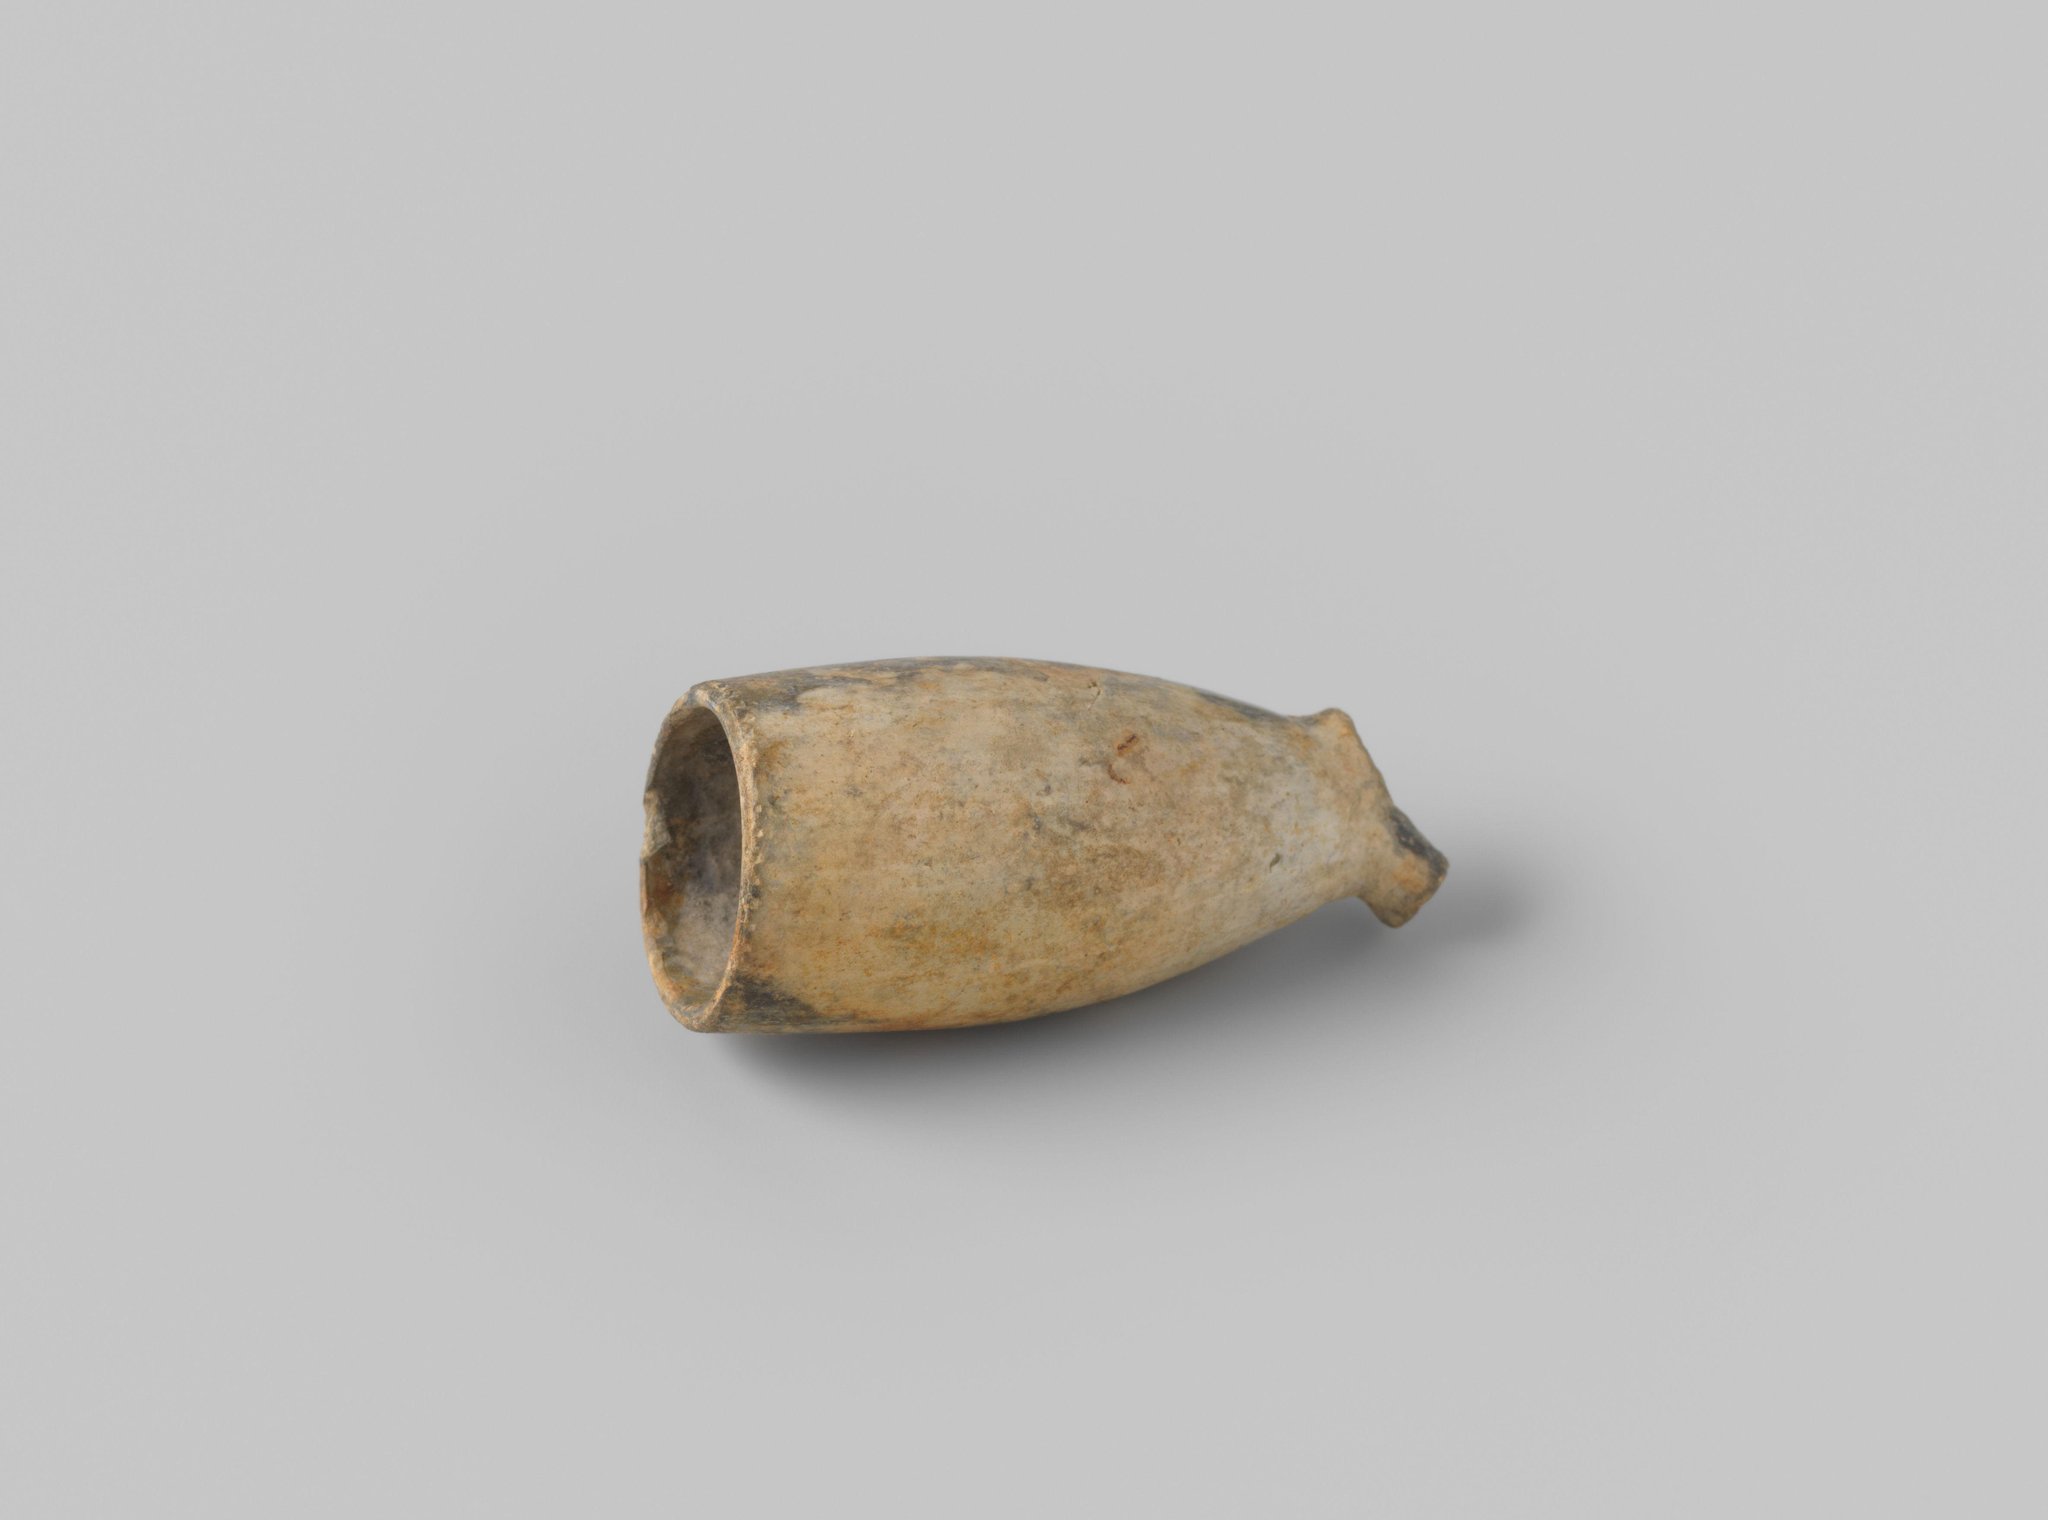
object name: pipe bowl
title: Pijpenkop uit het wrak van de Oost-Indiëvaarder Hollandia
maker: Anonymous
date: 1700-1743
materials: clay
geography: netherlands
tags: verenigde oostindische compagnie, hollandia (schip), annet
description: Pipe, bowl, heelmark: crowned 57; no hsm.